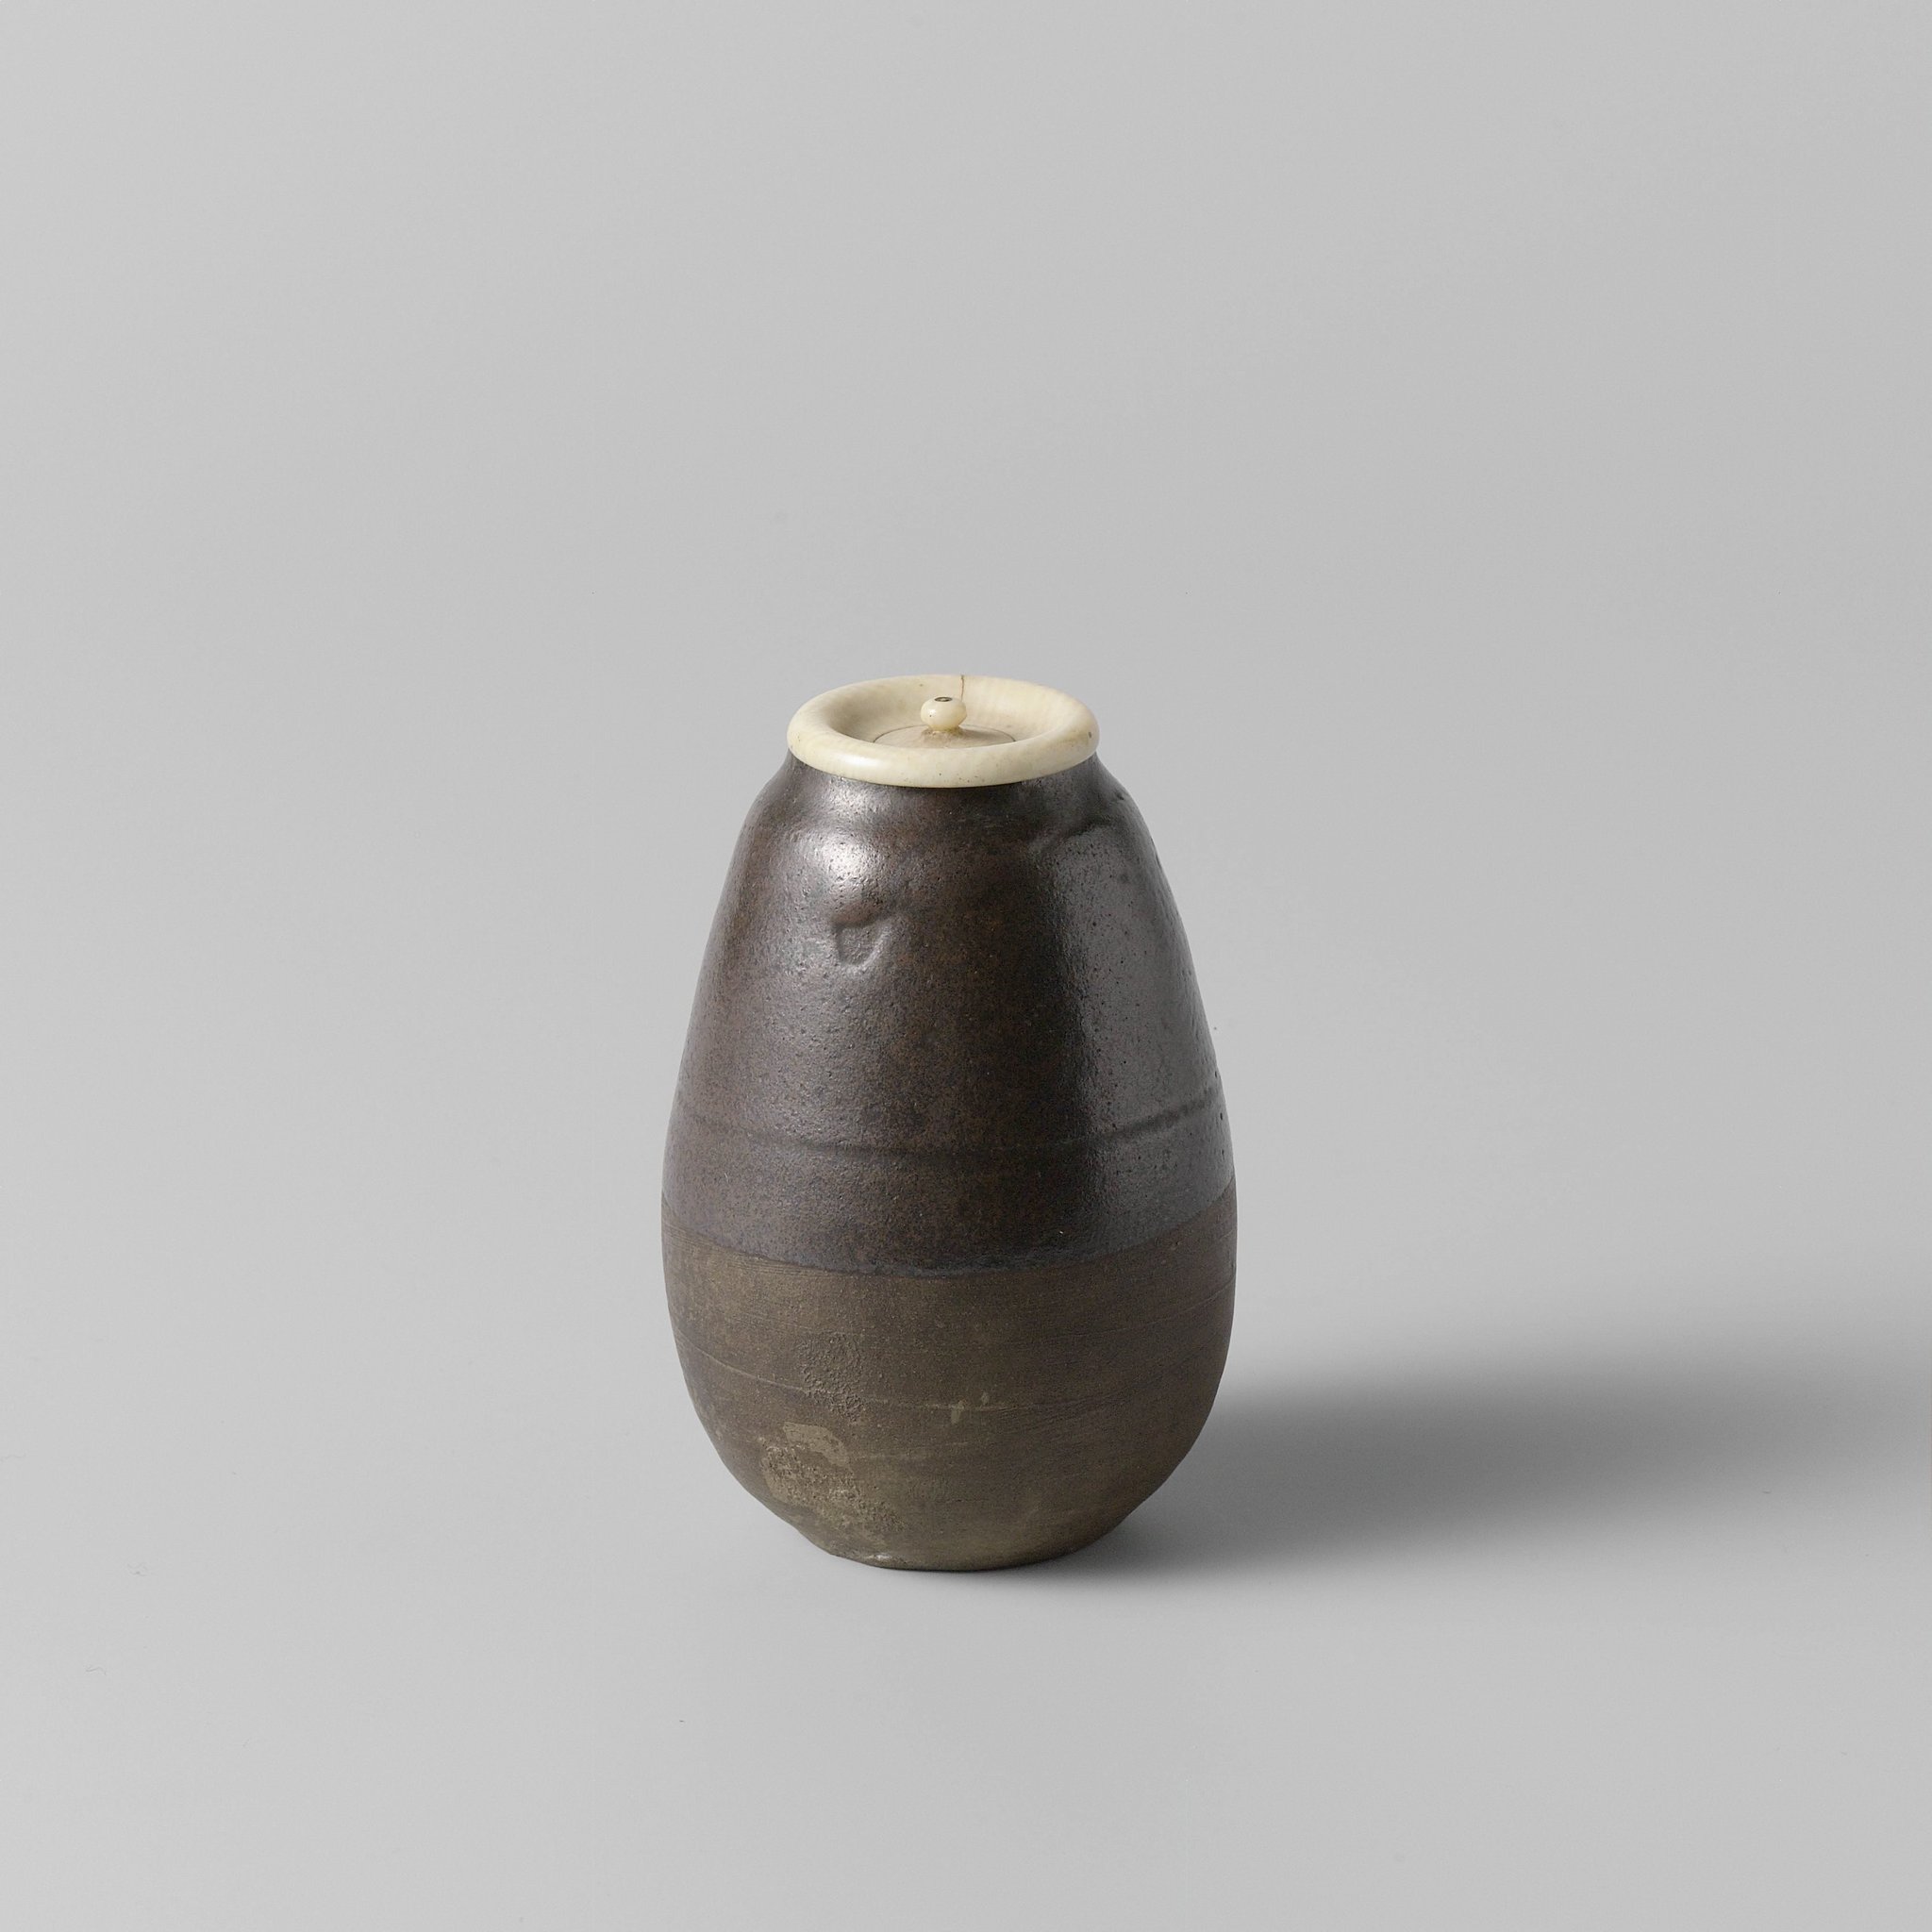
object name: chaire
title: Tea caddy with a darkbrown glaze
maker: Anonymous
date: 1600-1800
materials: glaze, ivory, stoneware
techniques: firing, turning, vitrification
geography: japan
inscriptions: label: ‘Kyushu’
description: Tea caddy. Japan, central Honshû, Seto or Mino. Late 16th century. Stoneware, Seto or Mino ware. Westendorp bequest.